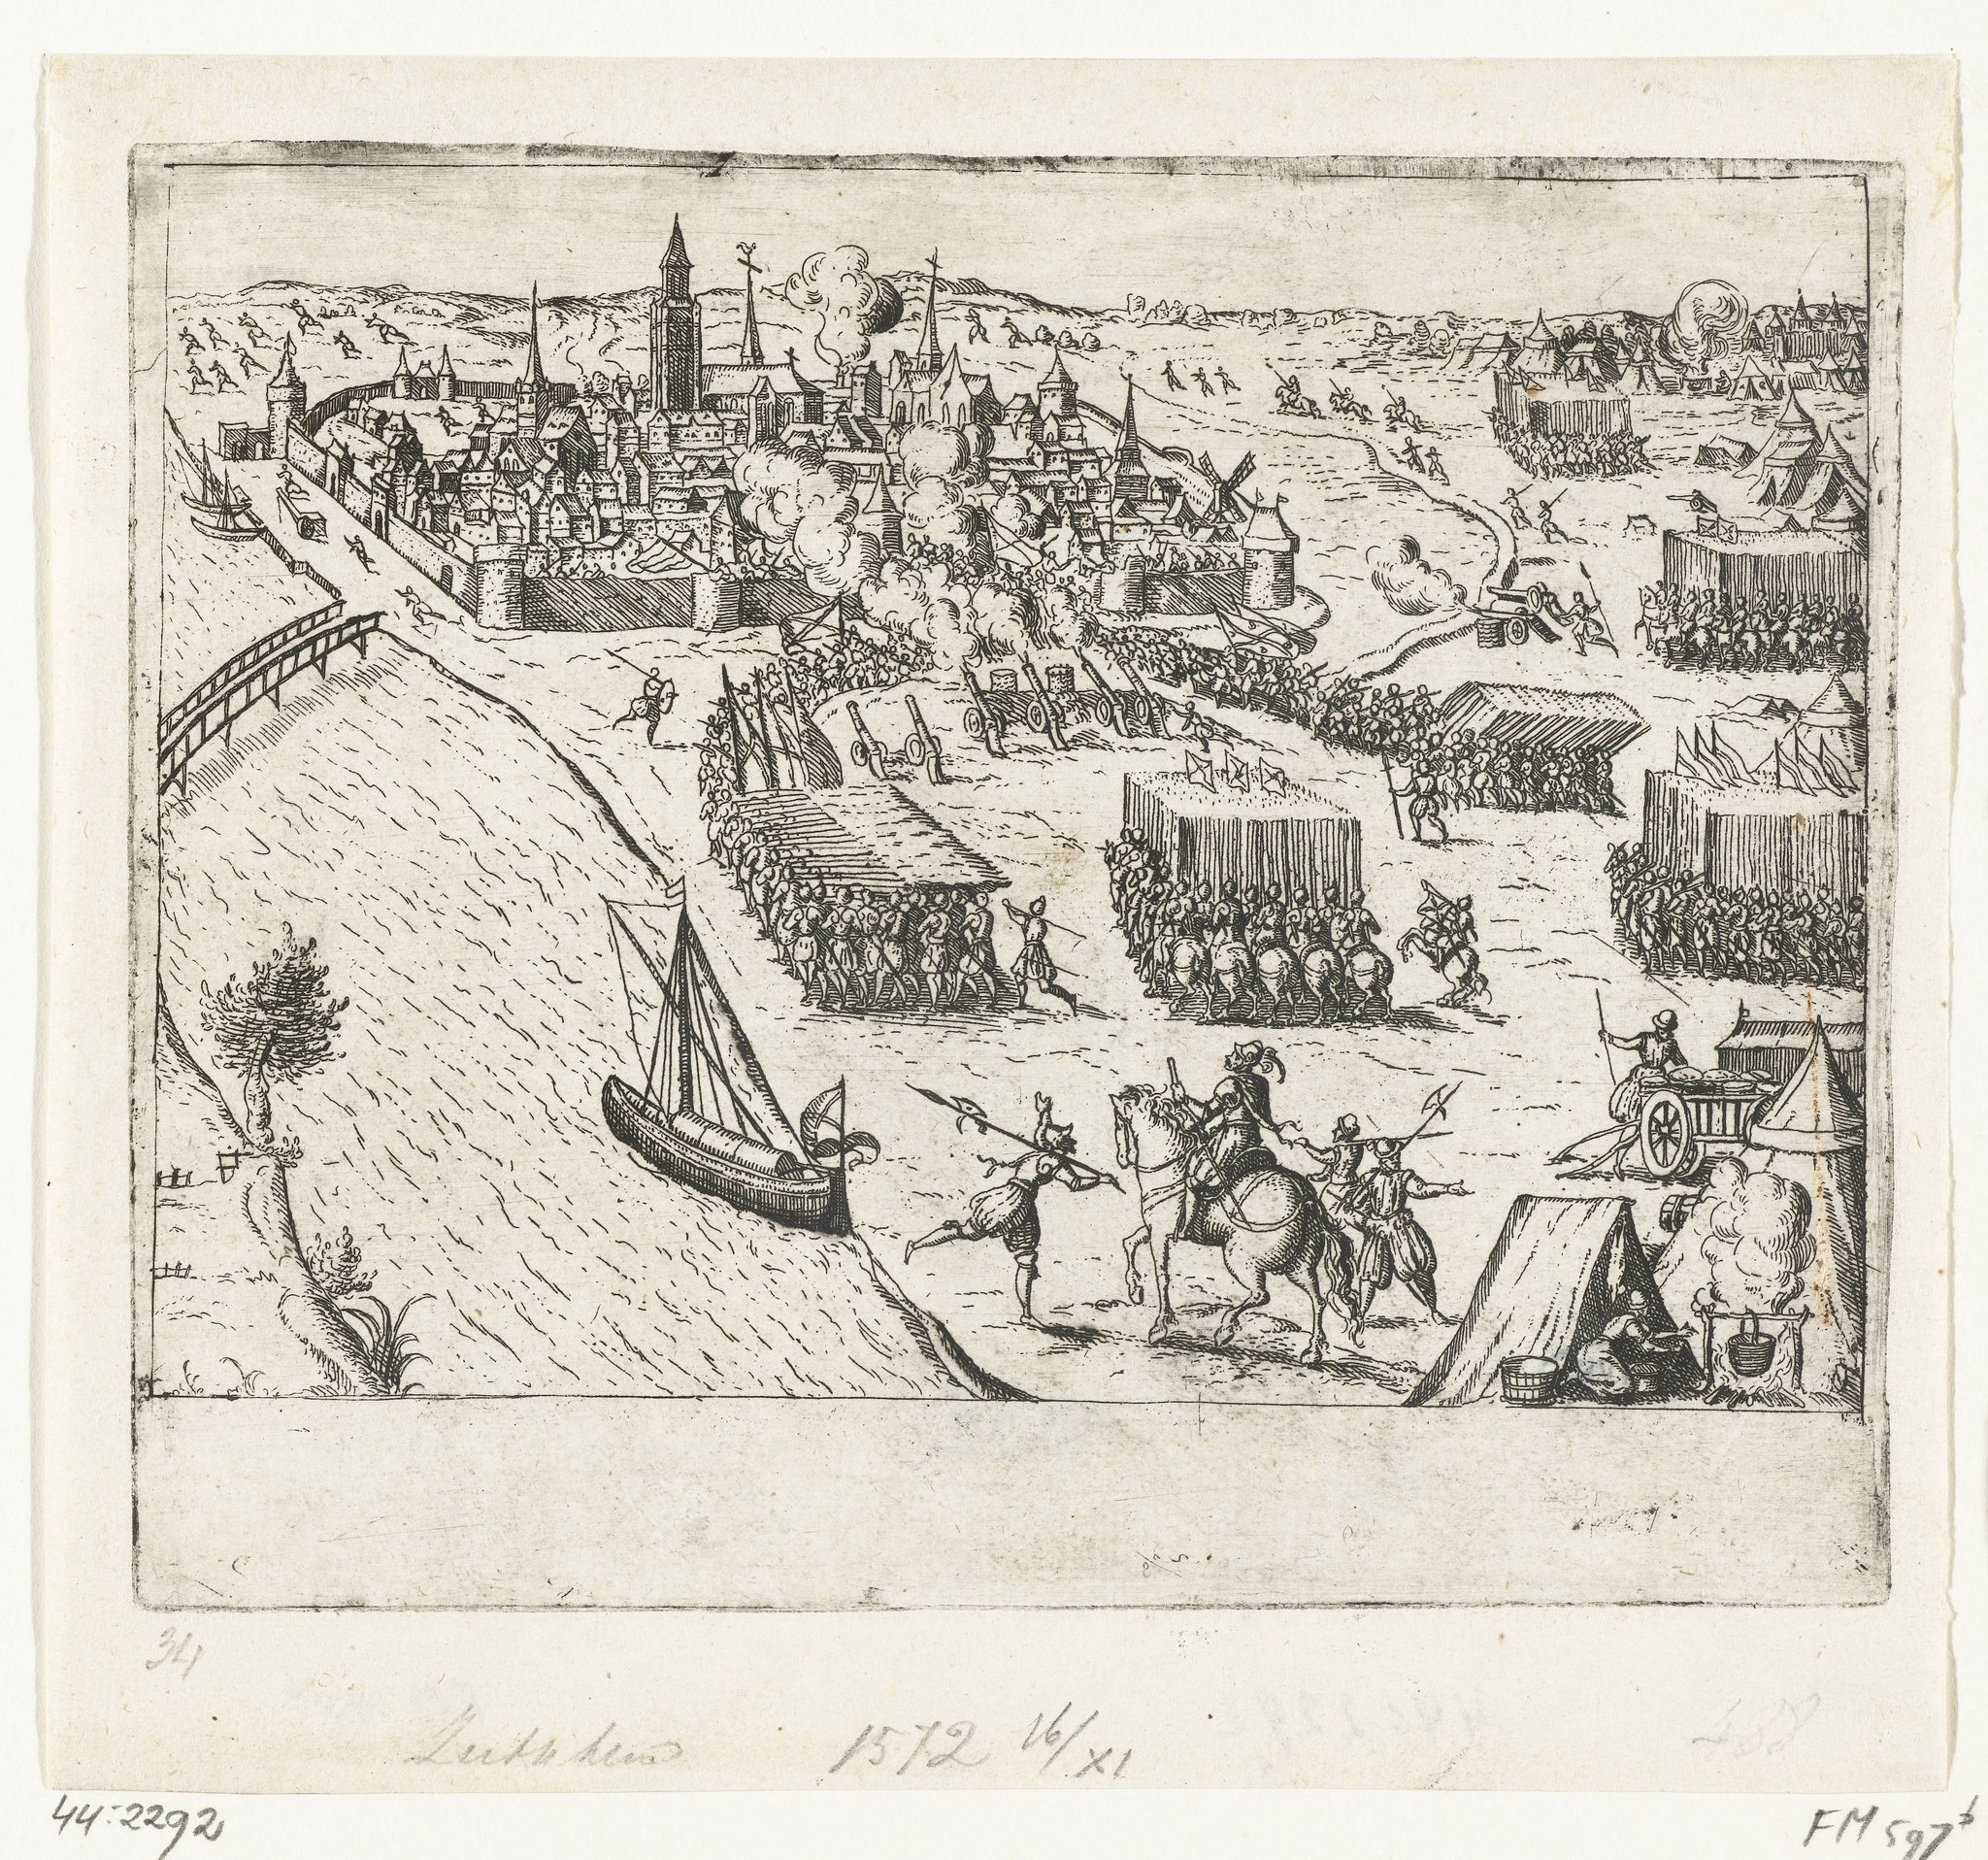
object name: print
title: Zutphen ingenomen door Don Frederik, 1572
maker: Anonymous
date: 1613-1615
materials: paper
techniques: etching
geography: germany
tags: siege, position war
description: Beschieting en bestorming van Zutphen door de Spaanse troepen onder Don Frederik, 16 november 1572. Gezicht vanuit het legerkamp, op de voorgrond Don Frederik te paard, in de verte de belegerde stad. Onversneden plaat met grote marges, vóór alle teksten.